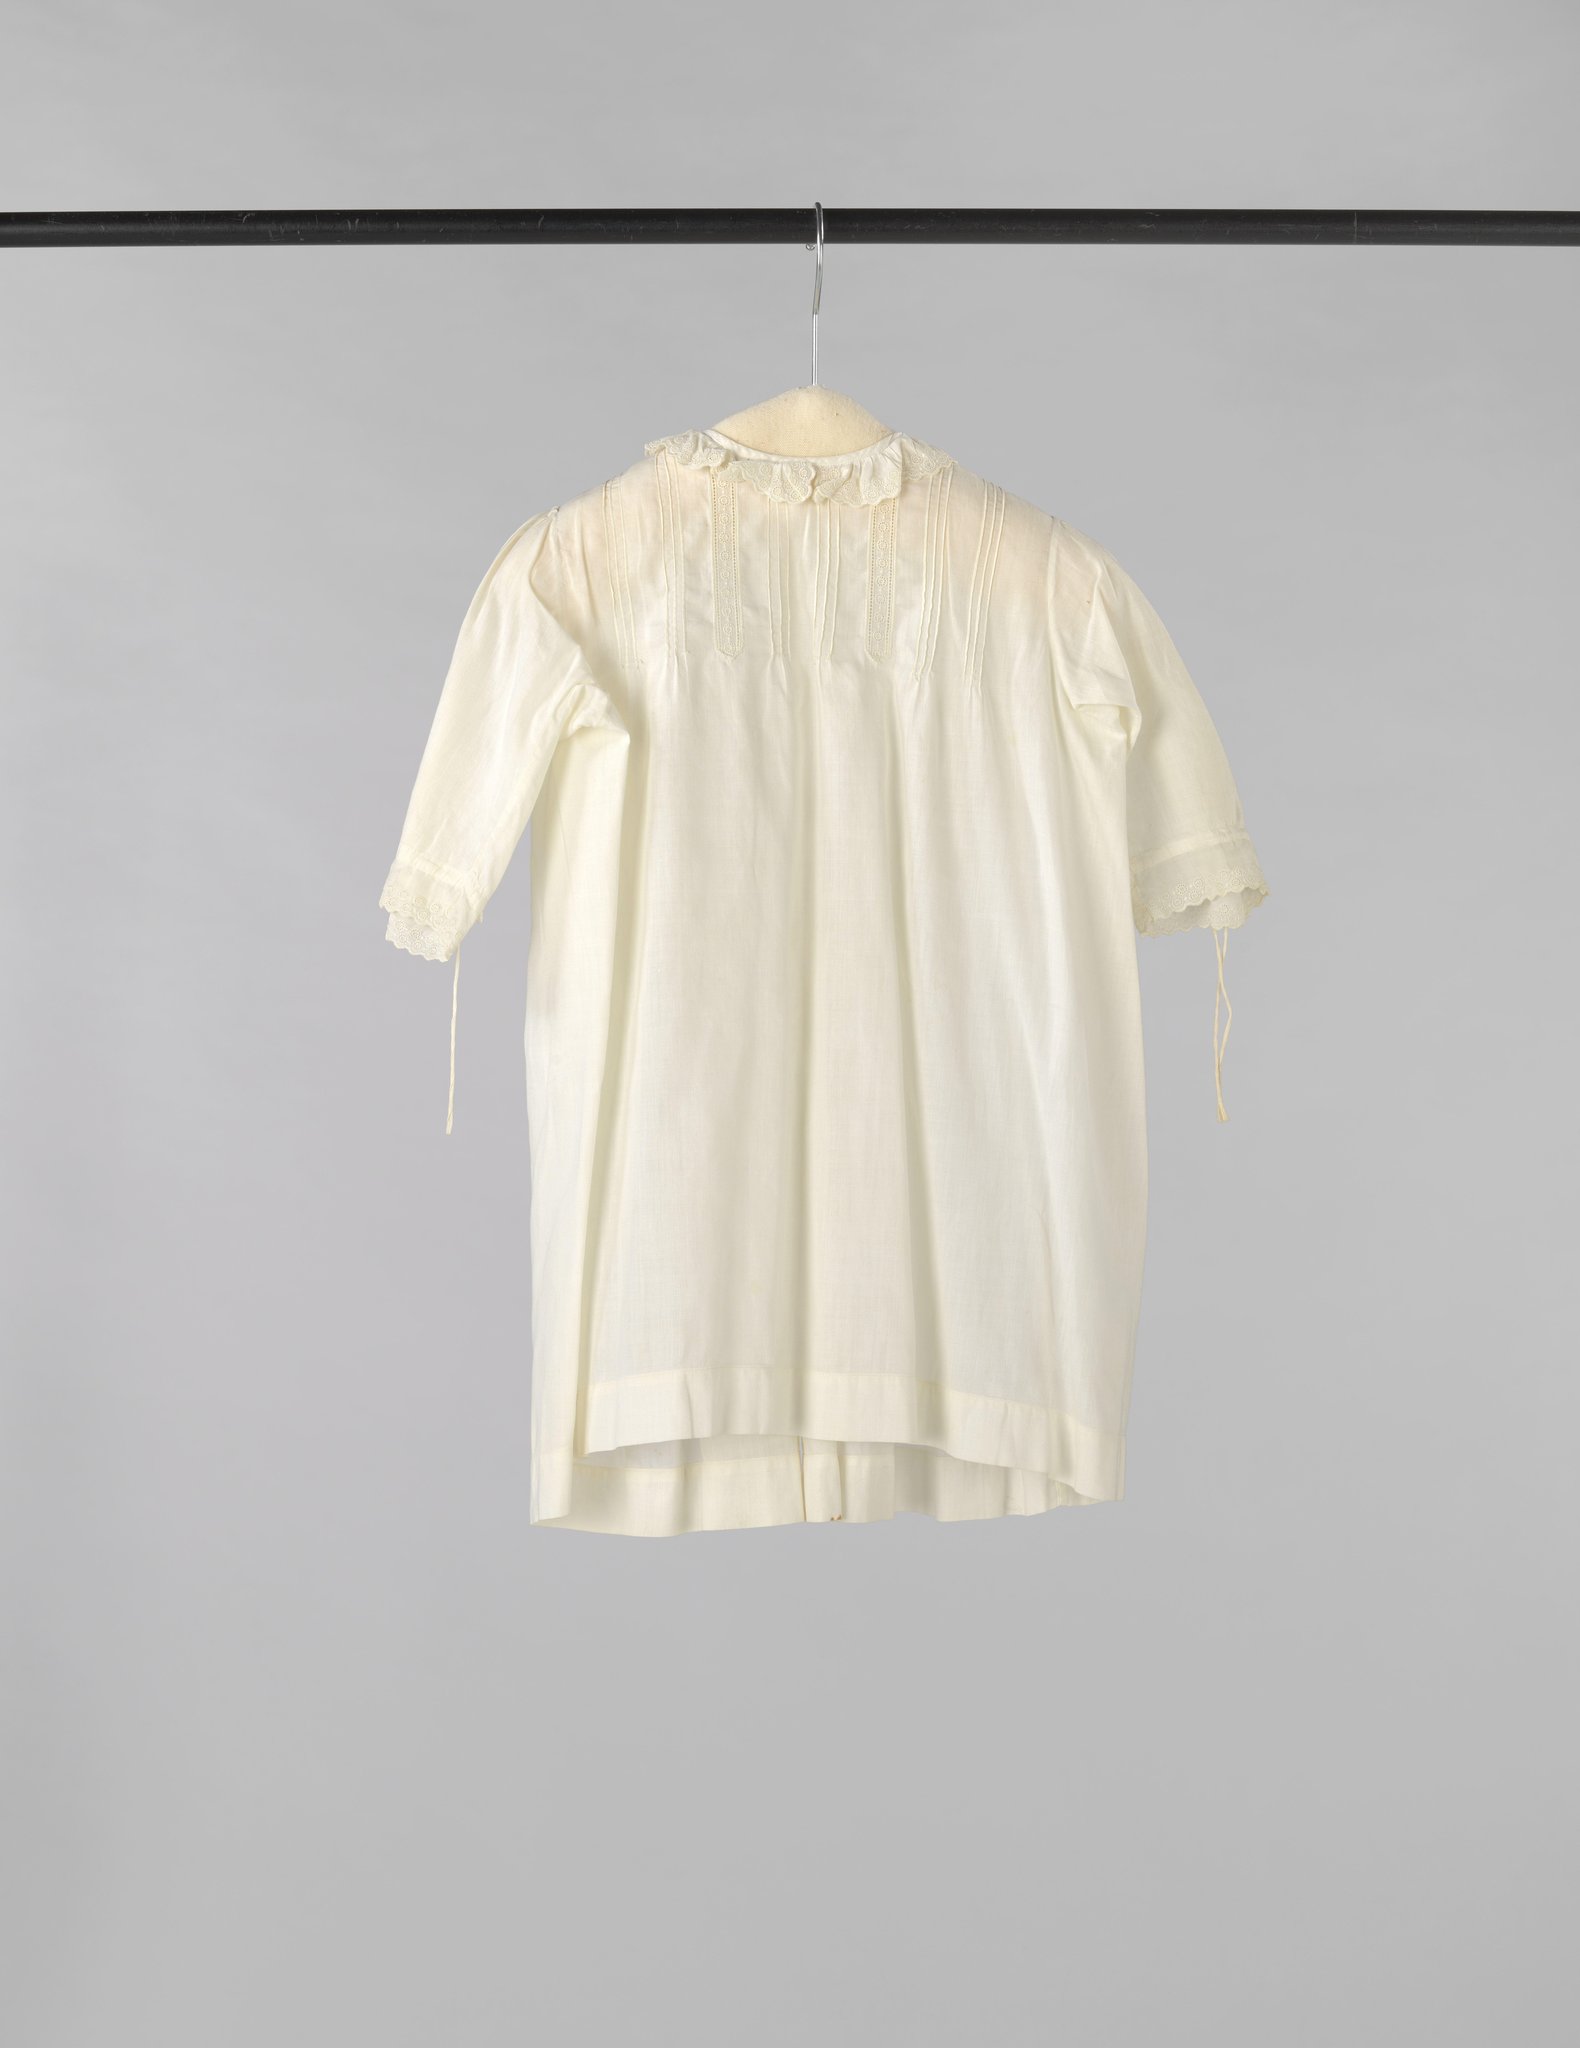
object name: apron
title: Kinderschort van wit katoen, versierd met tussenzetsels en stroken wit borduurwerk en oprijgen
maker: Anonymous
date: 1922-1926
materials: cotton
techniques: embroidered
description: Kinderschort van wit katoen, versierd met tussenzetsels en stroken wit borduurwerk en oprijgen.